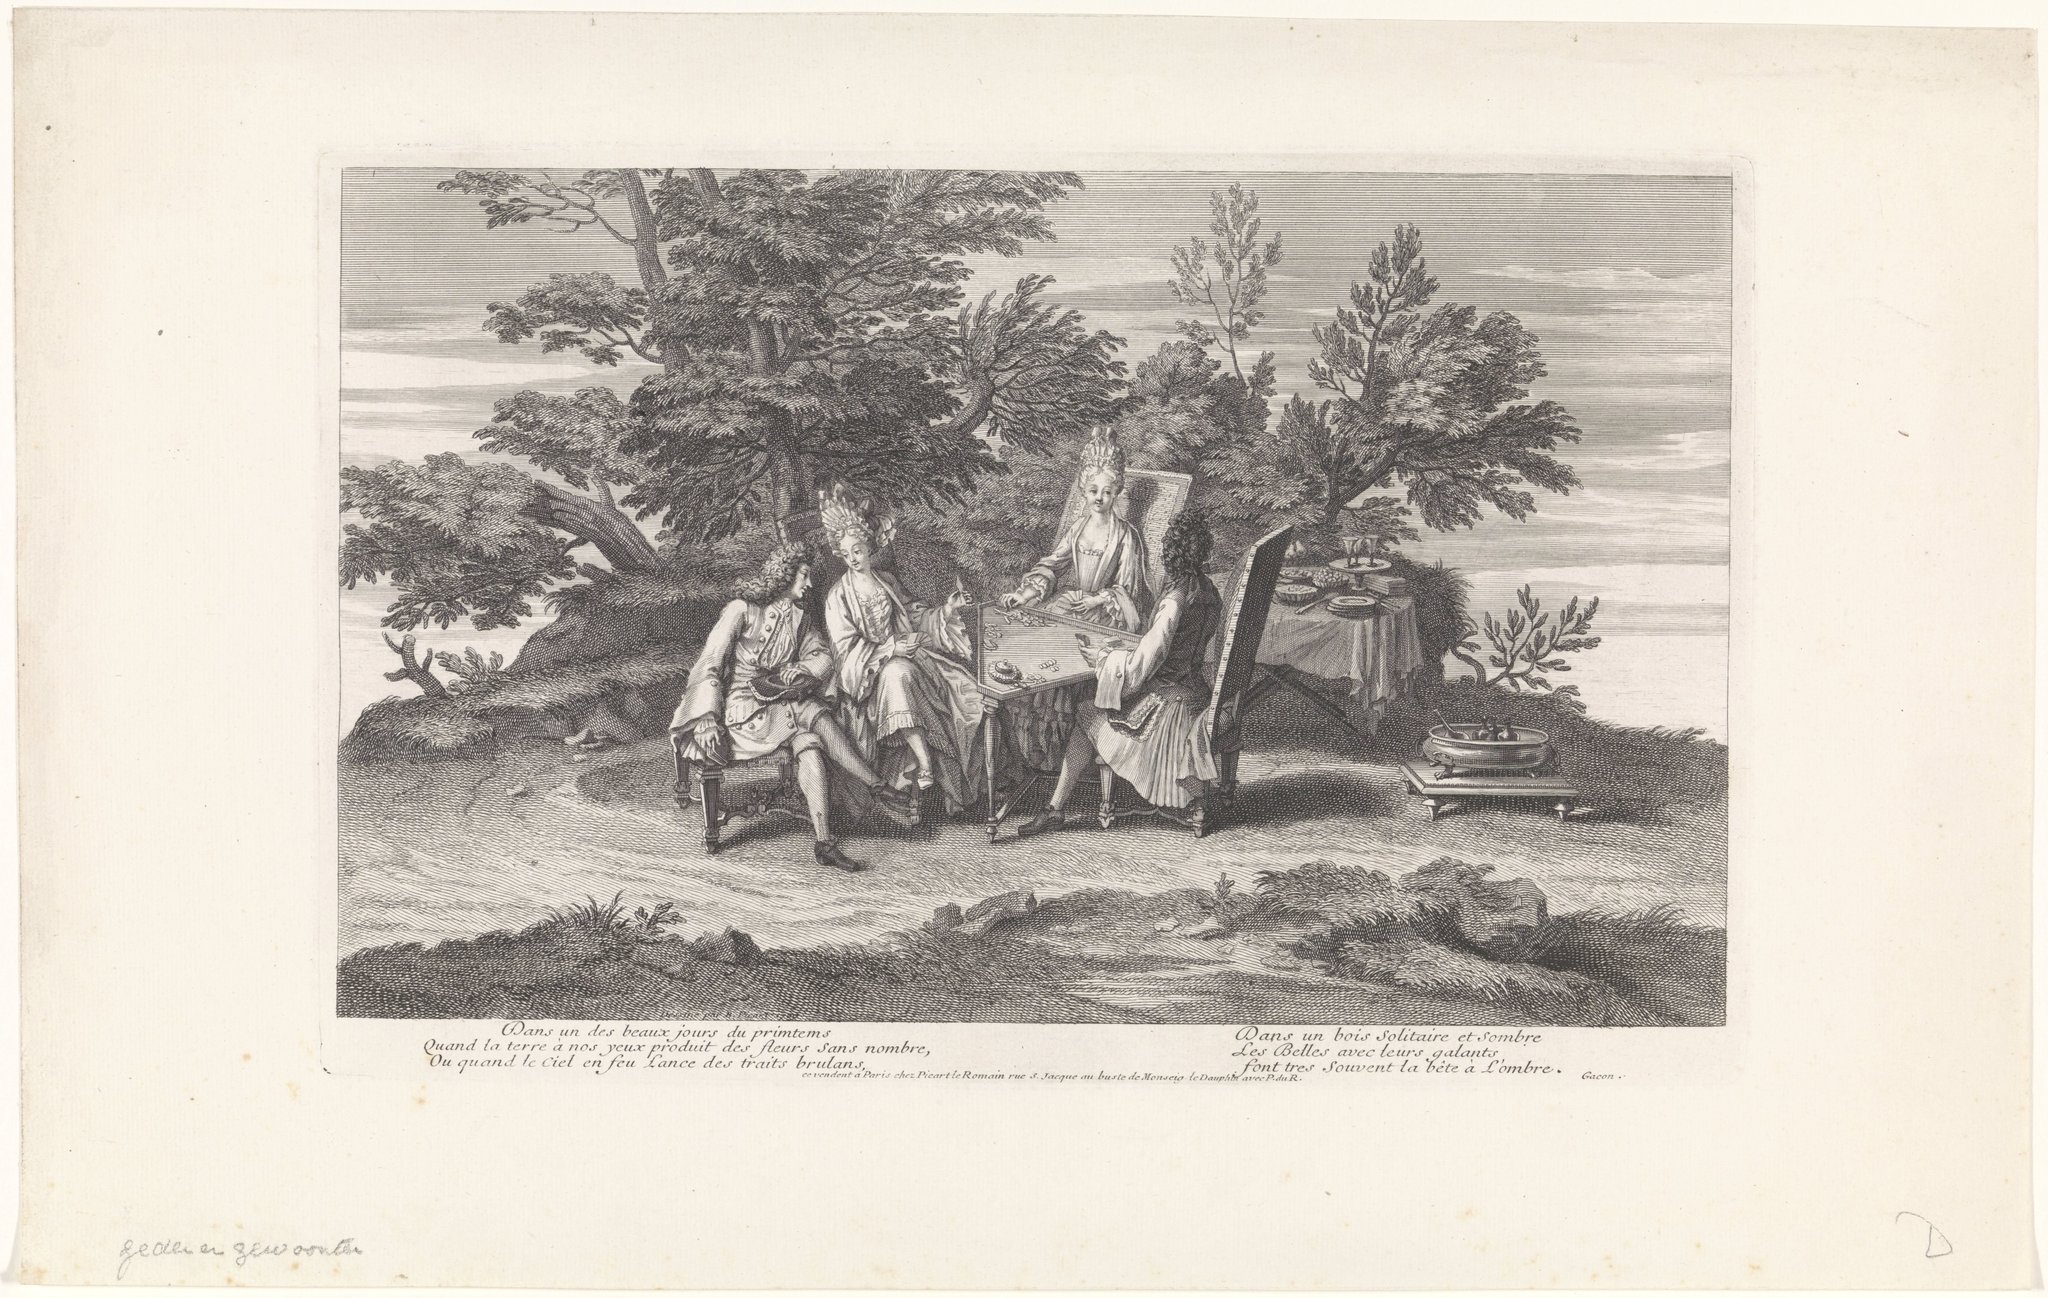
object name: print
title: Elegant gezelschap speelt het kaartspel Jeu de l'hombre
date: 1709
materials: paper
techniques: engraving, etching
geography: paris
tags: card games, party games with erotic implications, e.g.: kissing contest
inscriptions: collector's mark: Lugt 2228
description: Een gezelschap van twee mannen en twee vrouwen speelt het kaartspel Jeu de l'hombre aan een driehoekige tafel in een park. In dit spel wordt degene die een kaart vraagt "hombre" genoemd. In de marge een zesregelig gedicht, in twee kolommen, in het Frans.